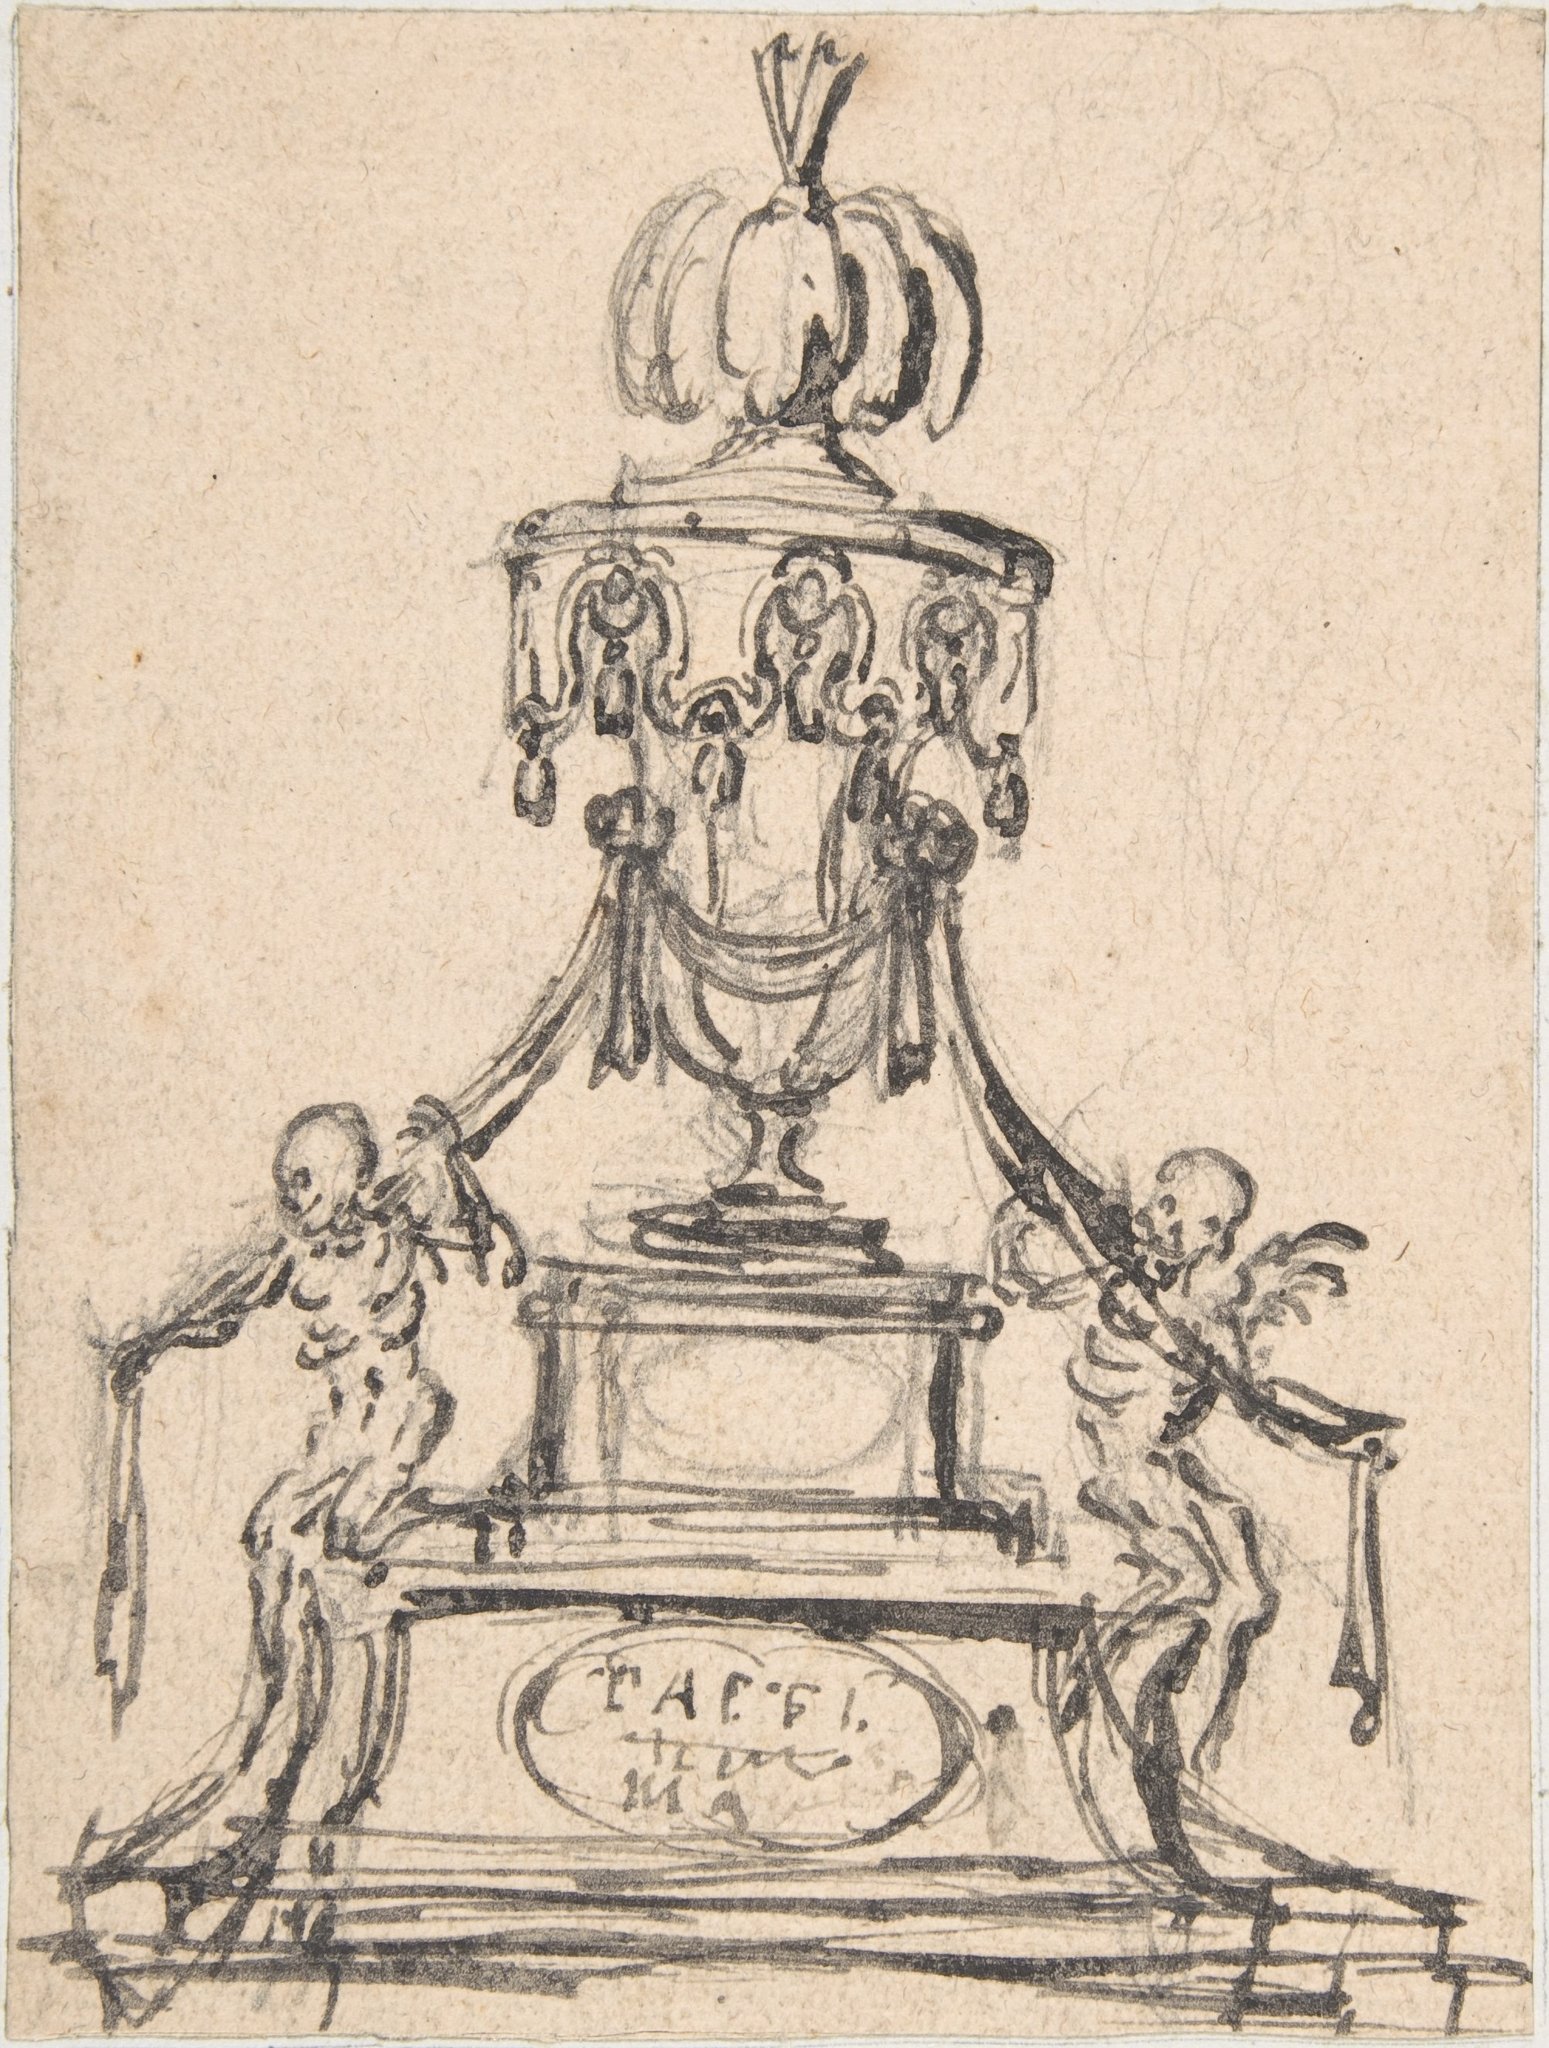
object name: drawing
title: Tomb Monument with Skeletons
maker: anonymous, italian, 17th century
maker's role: artist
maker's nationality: italian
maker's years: 1600-1700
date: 1601-1700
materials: graphite, ink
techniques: pen, drawing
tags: tombs,skeletons